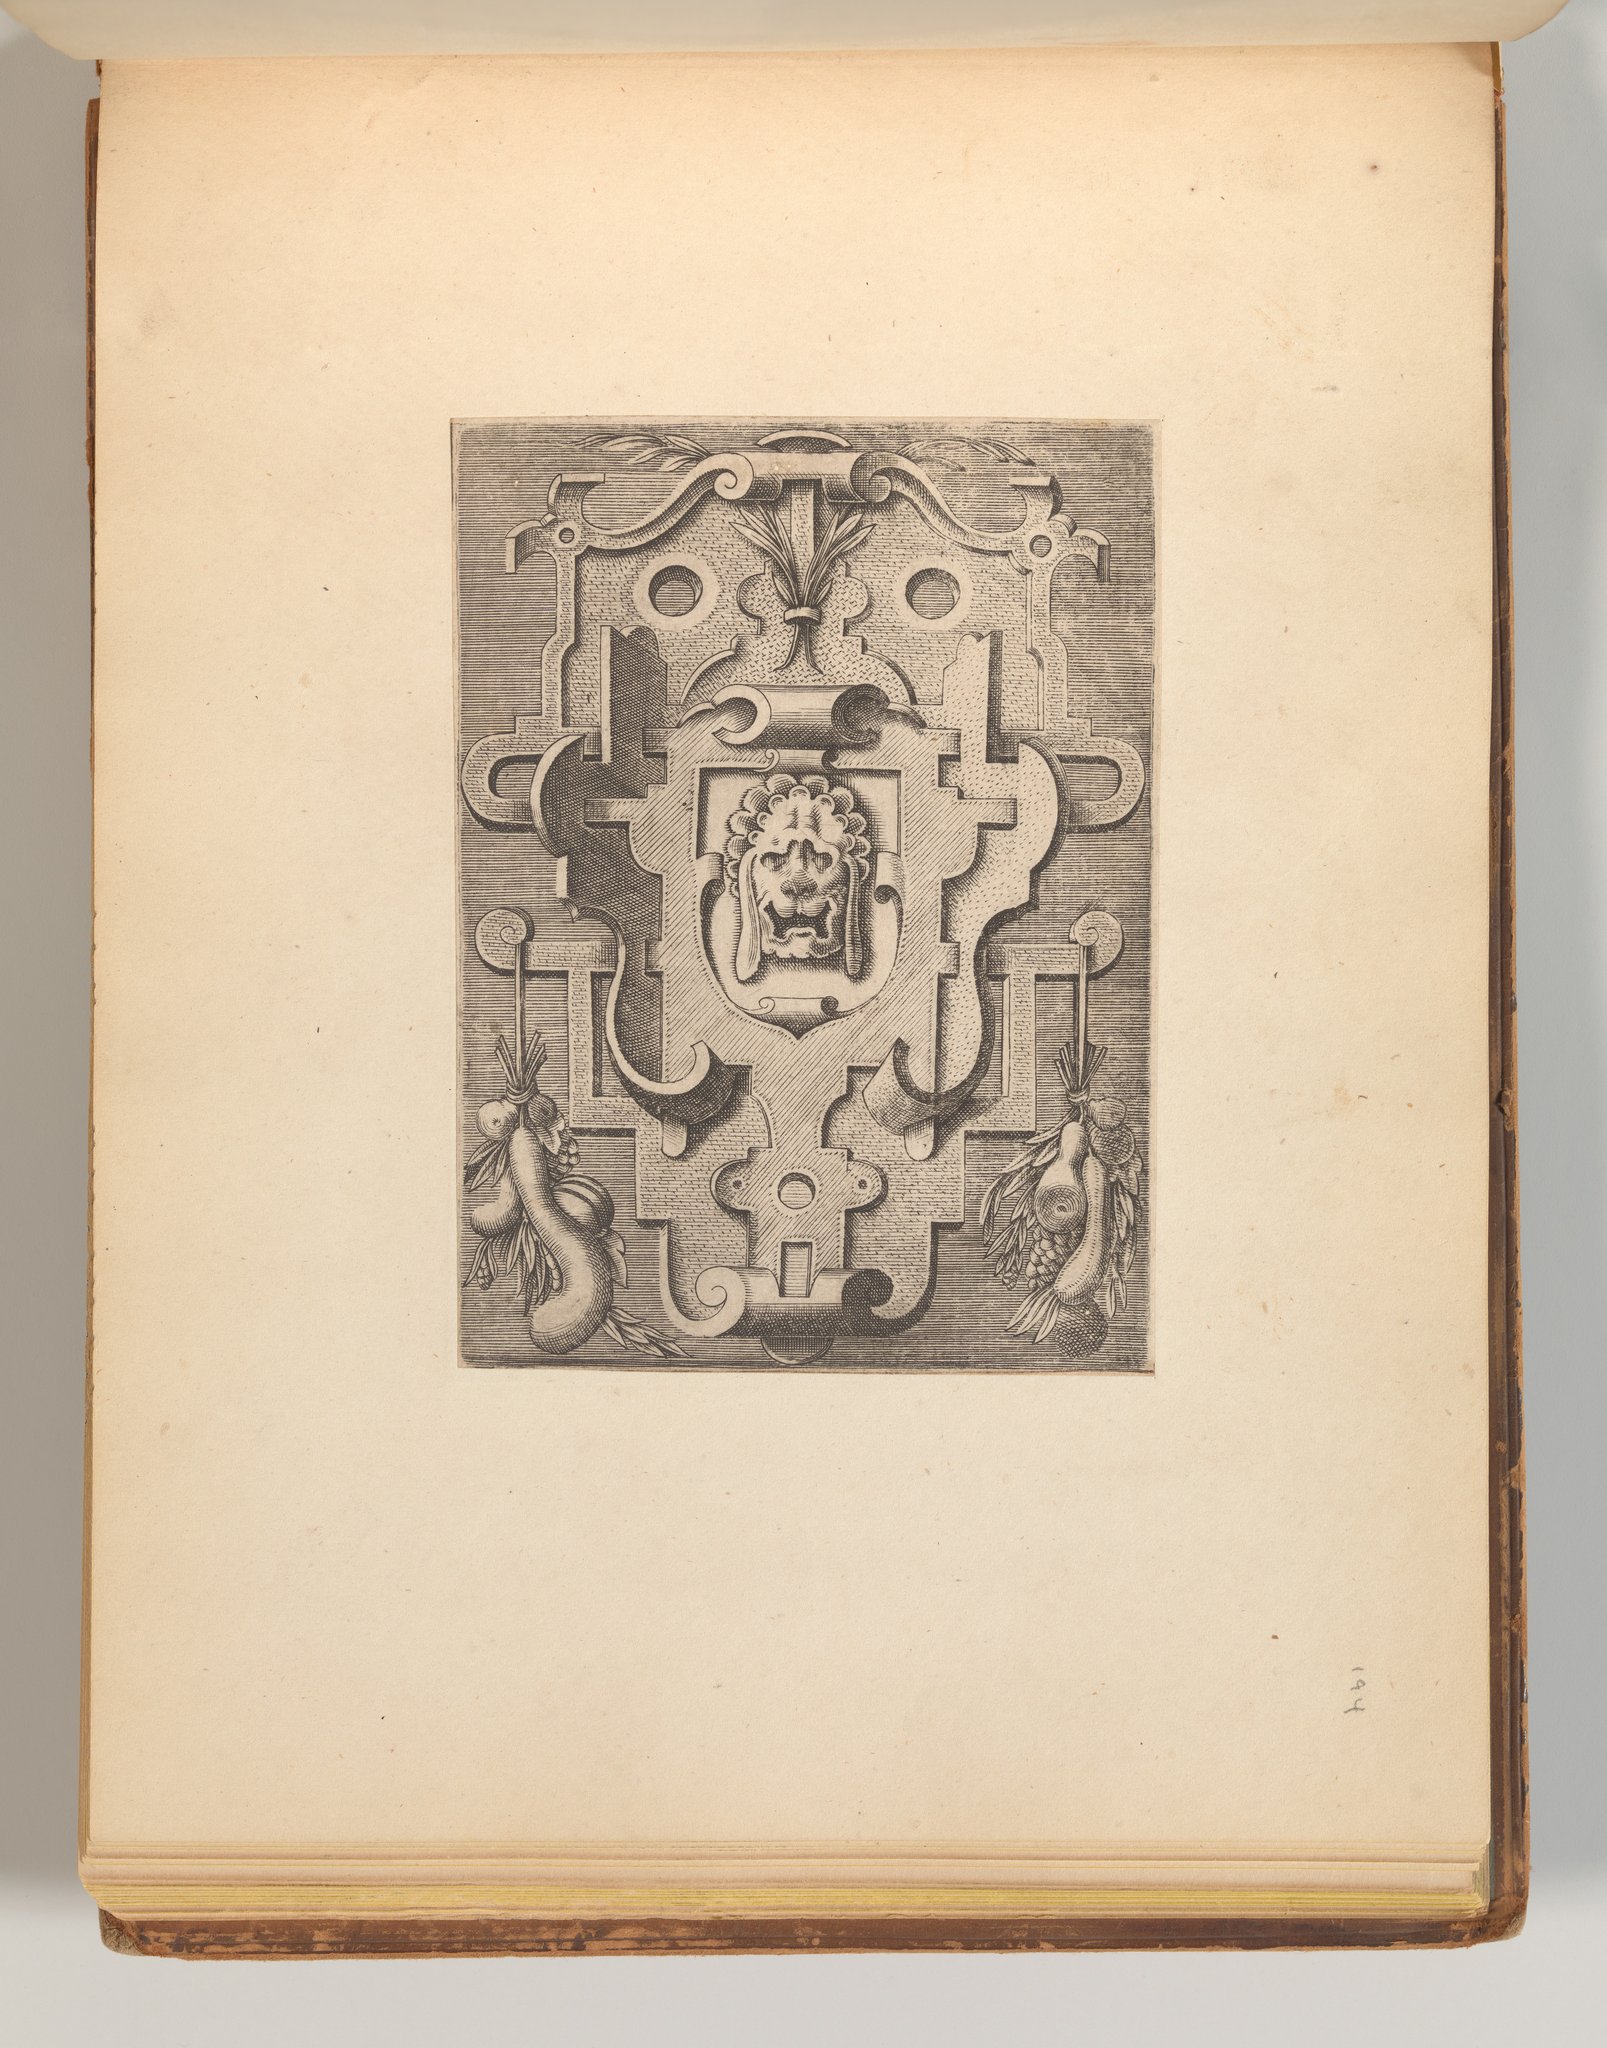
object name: album print ornament architecture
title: Series of Cartouches, in: Targhe ed altri ornati di varie e capricciose invenzioni (Cartouches and other ornaments of various and capricious invention, page 36)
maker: cornelis bos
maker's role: artist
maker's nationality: netherlandish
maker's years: 1510-1556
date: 1545-1560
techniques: engraving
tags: masks,ornament